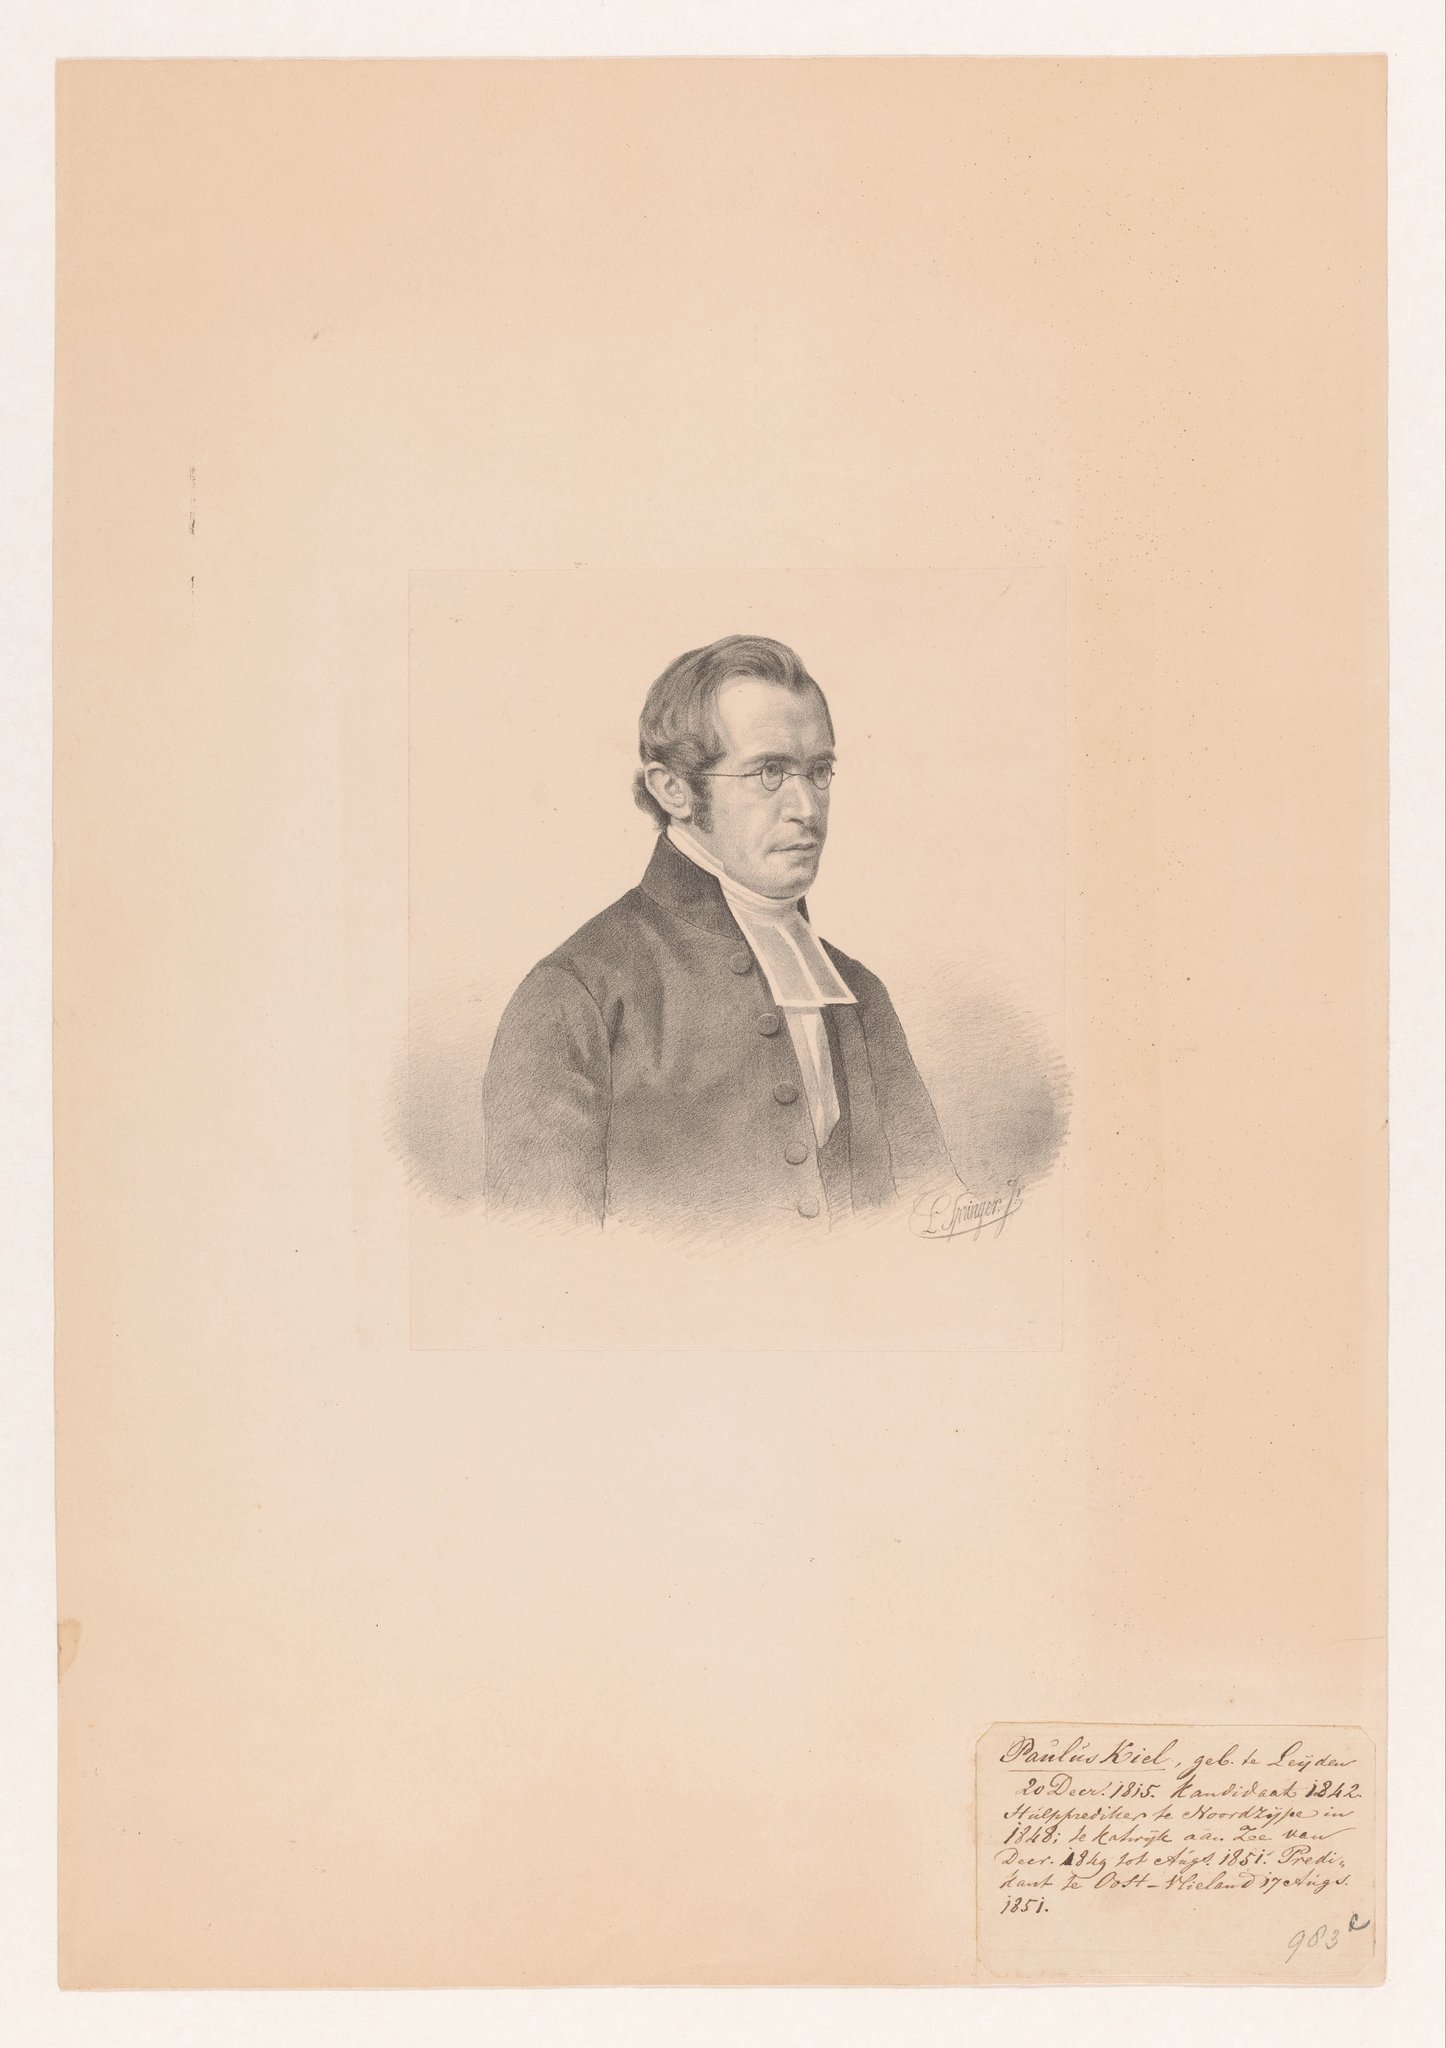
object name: print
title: Portret van Paulus Kiel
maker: leendert springer (ii)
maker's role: draughtsman, print maker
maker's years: 1831-1894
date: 1851-1894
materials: paper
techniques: lithograph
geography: netherlands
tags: historical persons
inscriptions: collector's mark: Lugt 2228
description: Onder het portret de biografische gegevens van de geportretteerde.